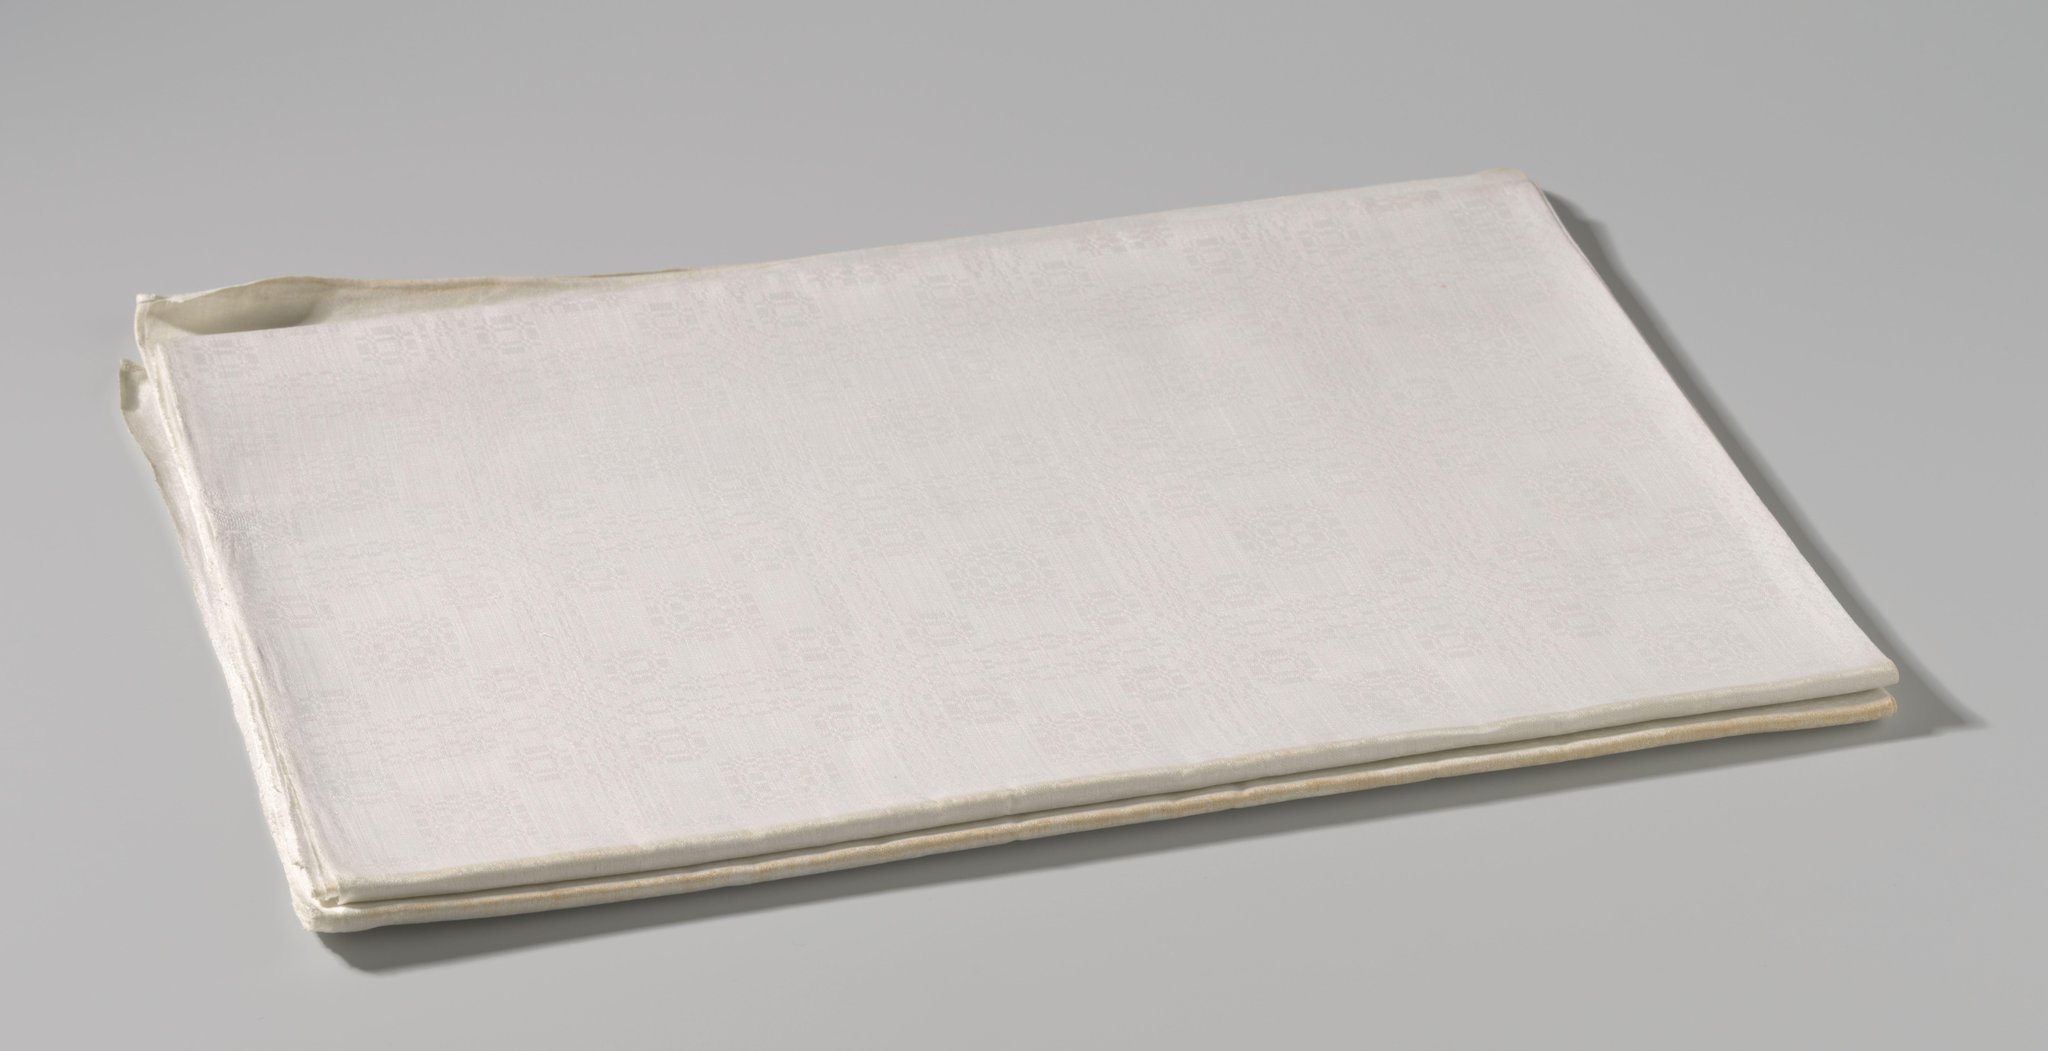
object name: tablecloth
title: Pellen. Merk: TC1.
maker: Anonymous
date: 1690-1728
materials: linen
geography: northern netherlands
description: Tafellaken van wit linnen met pellen patroon, merk TC 1